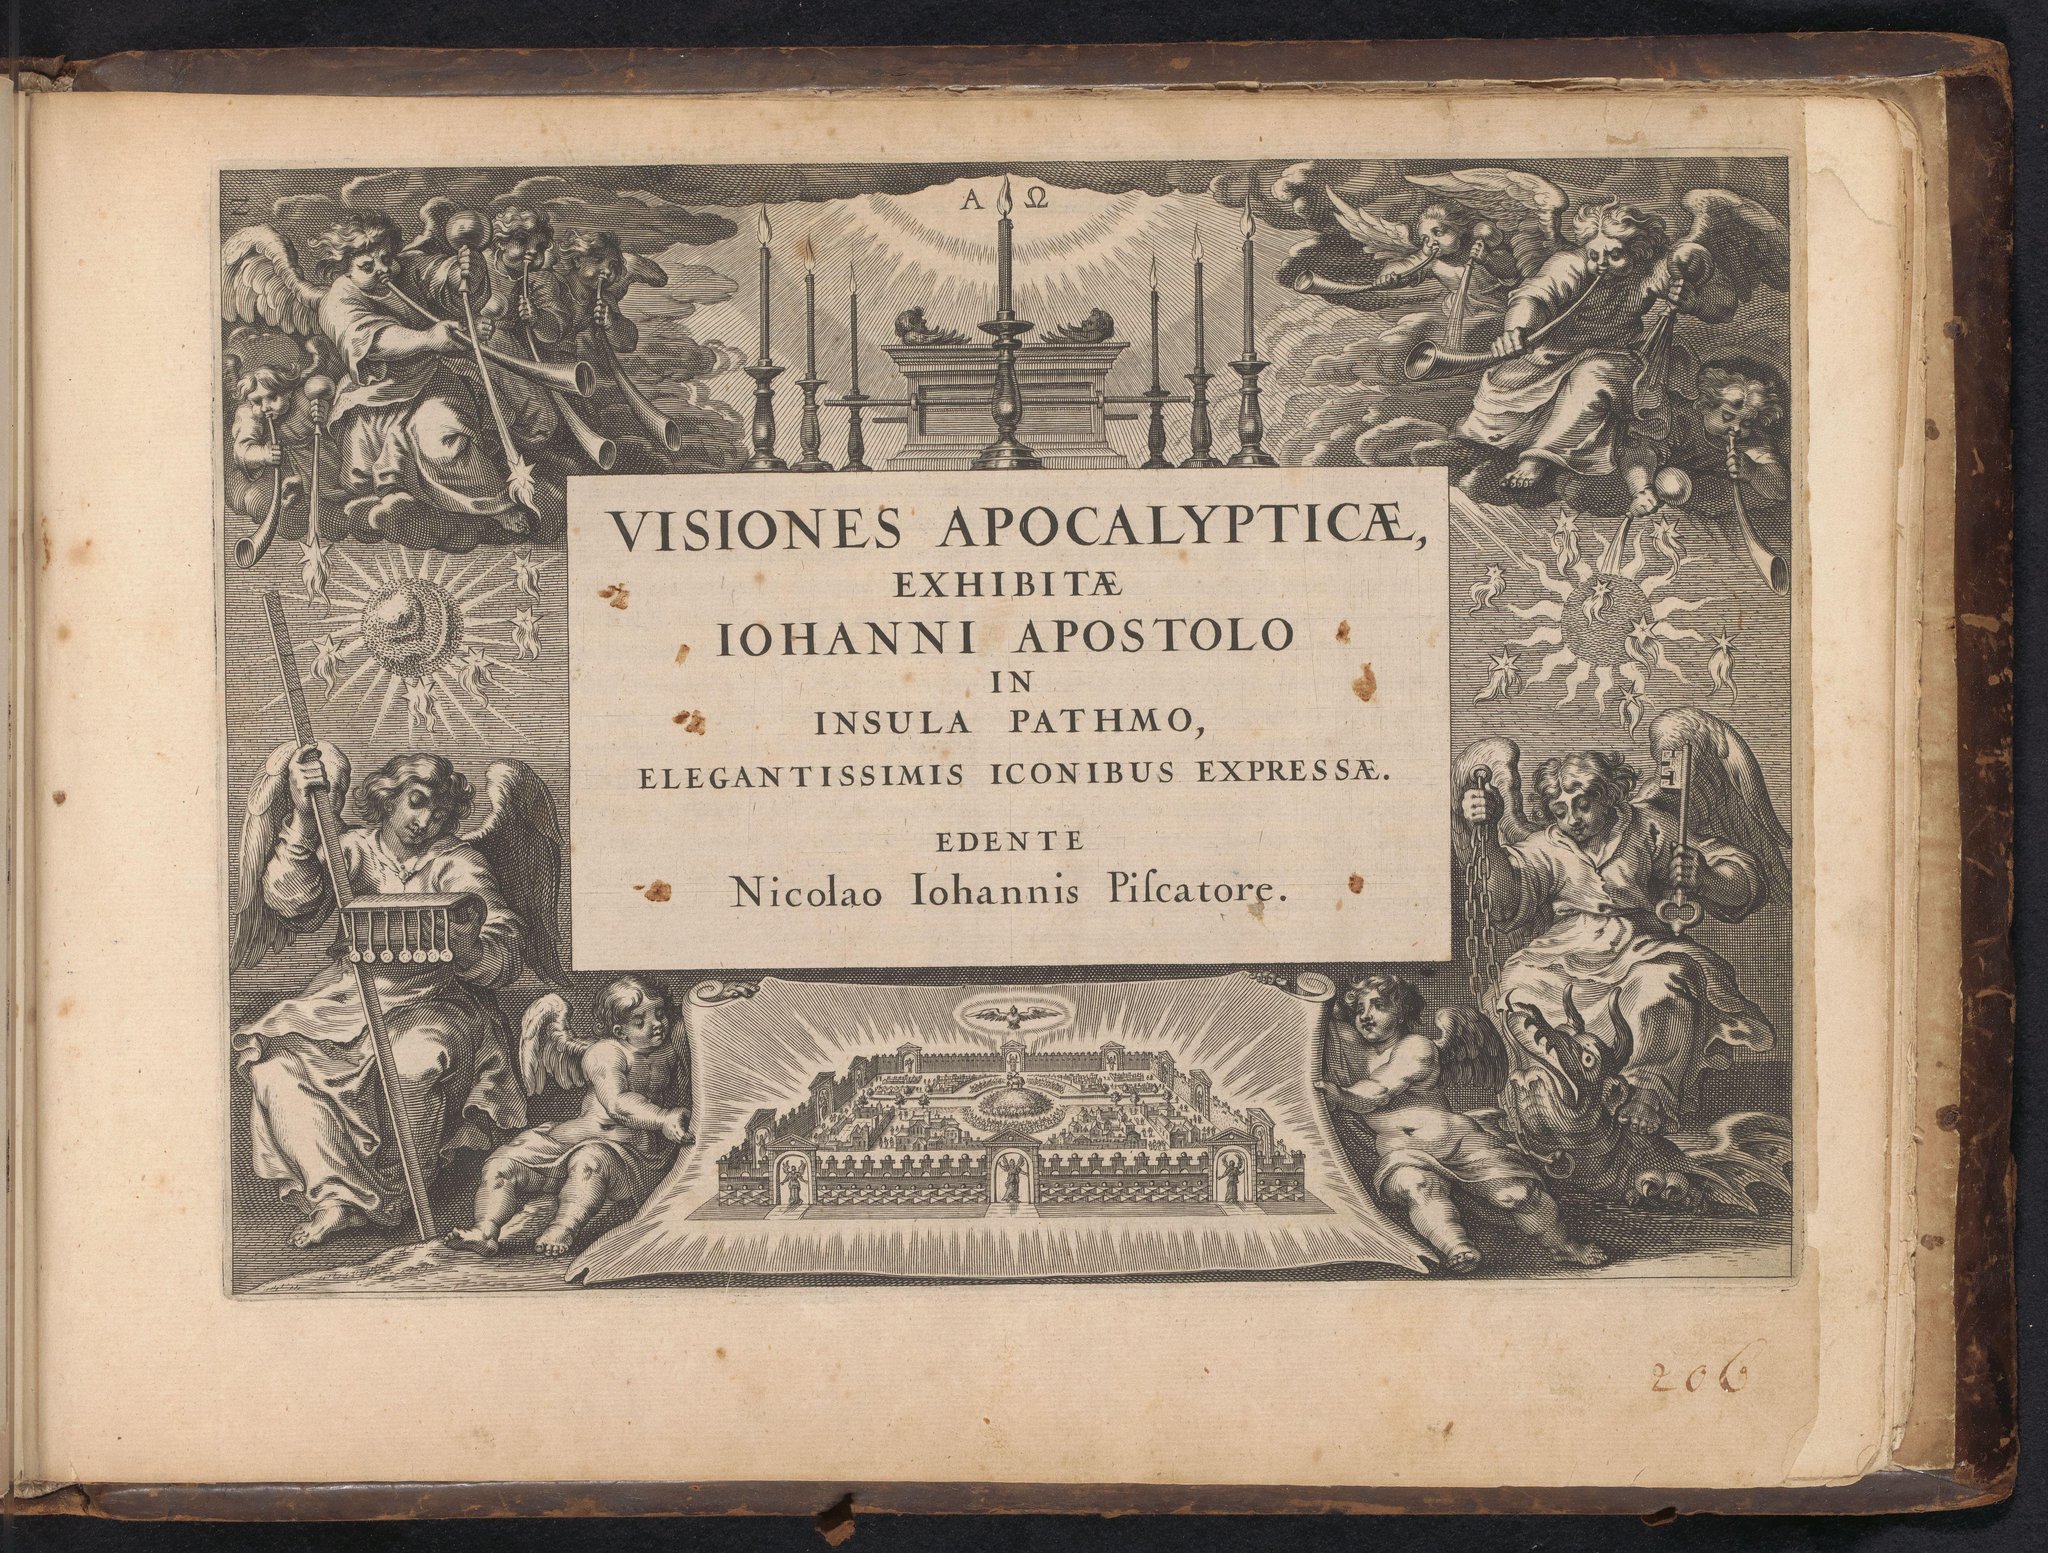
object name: titelprent, frontispice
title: Engelen presenteren verschillende objecten uit de openbaring van Johannes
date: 1643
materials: paper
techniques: engraving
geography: alkmaar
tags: the new jerusalem, the seven angels with trumpets ~ revelation of john, an angel with a key and a chain binds the dragon (satan) and casts him into the pit, the vision of the lamb and the book with the seven seals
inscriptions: number: ‘206’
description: Centraal de titel van de prentserie. In het kader presenteren engelen verschillende objecten uit de openbaring van Johannes. Linksonder een engel met het boek met de zeven zegels en een meetlat. Rechtsonder een engel met een sleutel en het geketende beest. In de bovenhoeken de zeven engelen met bazuinen. Midden boven de zeven kandelaren en de ark van het verbond. Midden onder het nieuwe Jeruzalem. Deze prent maakt deel uit van een album.